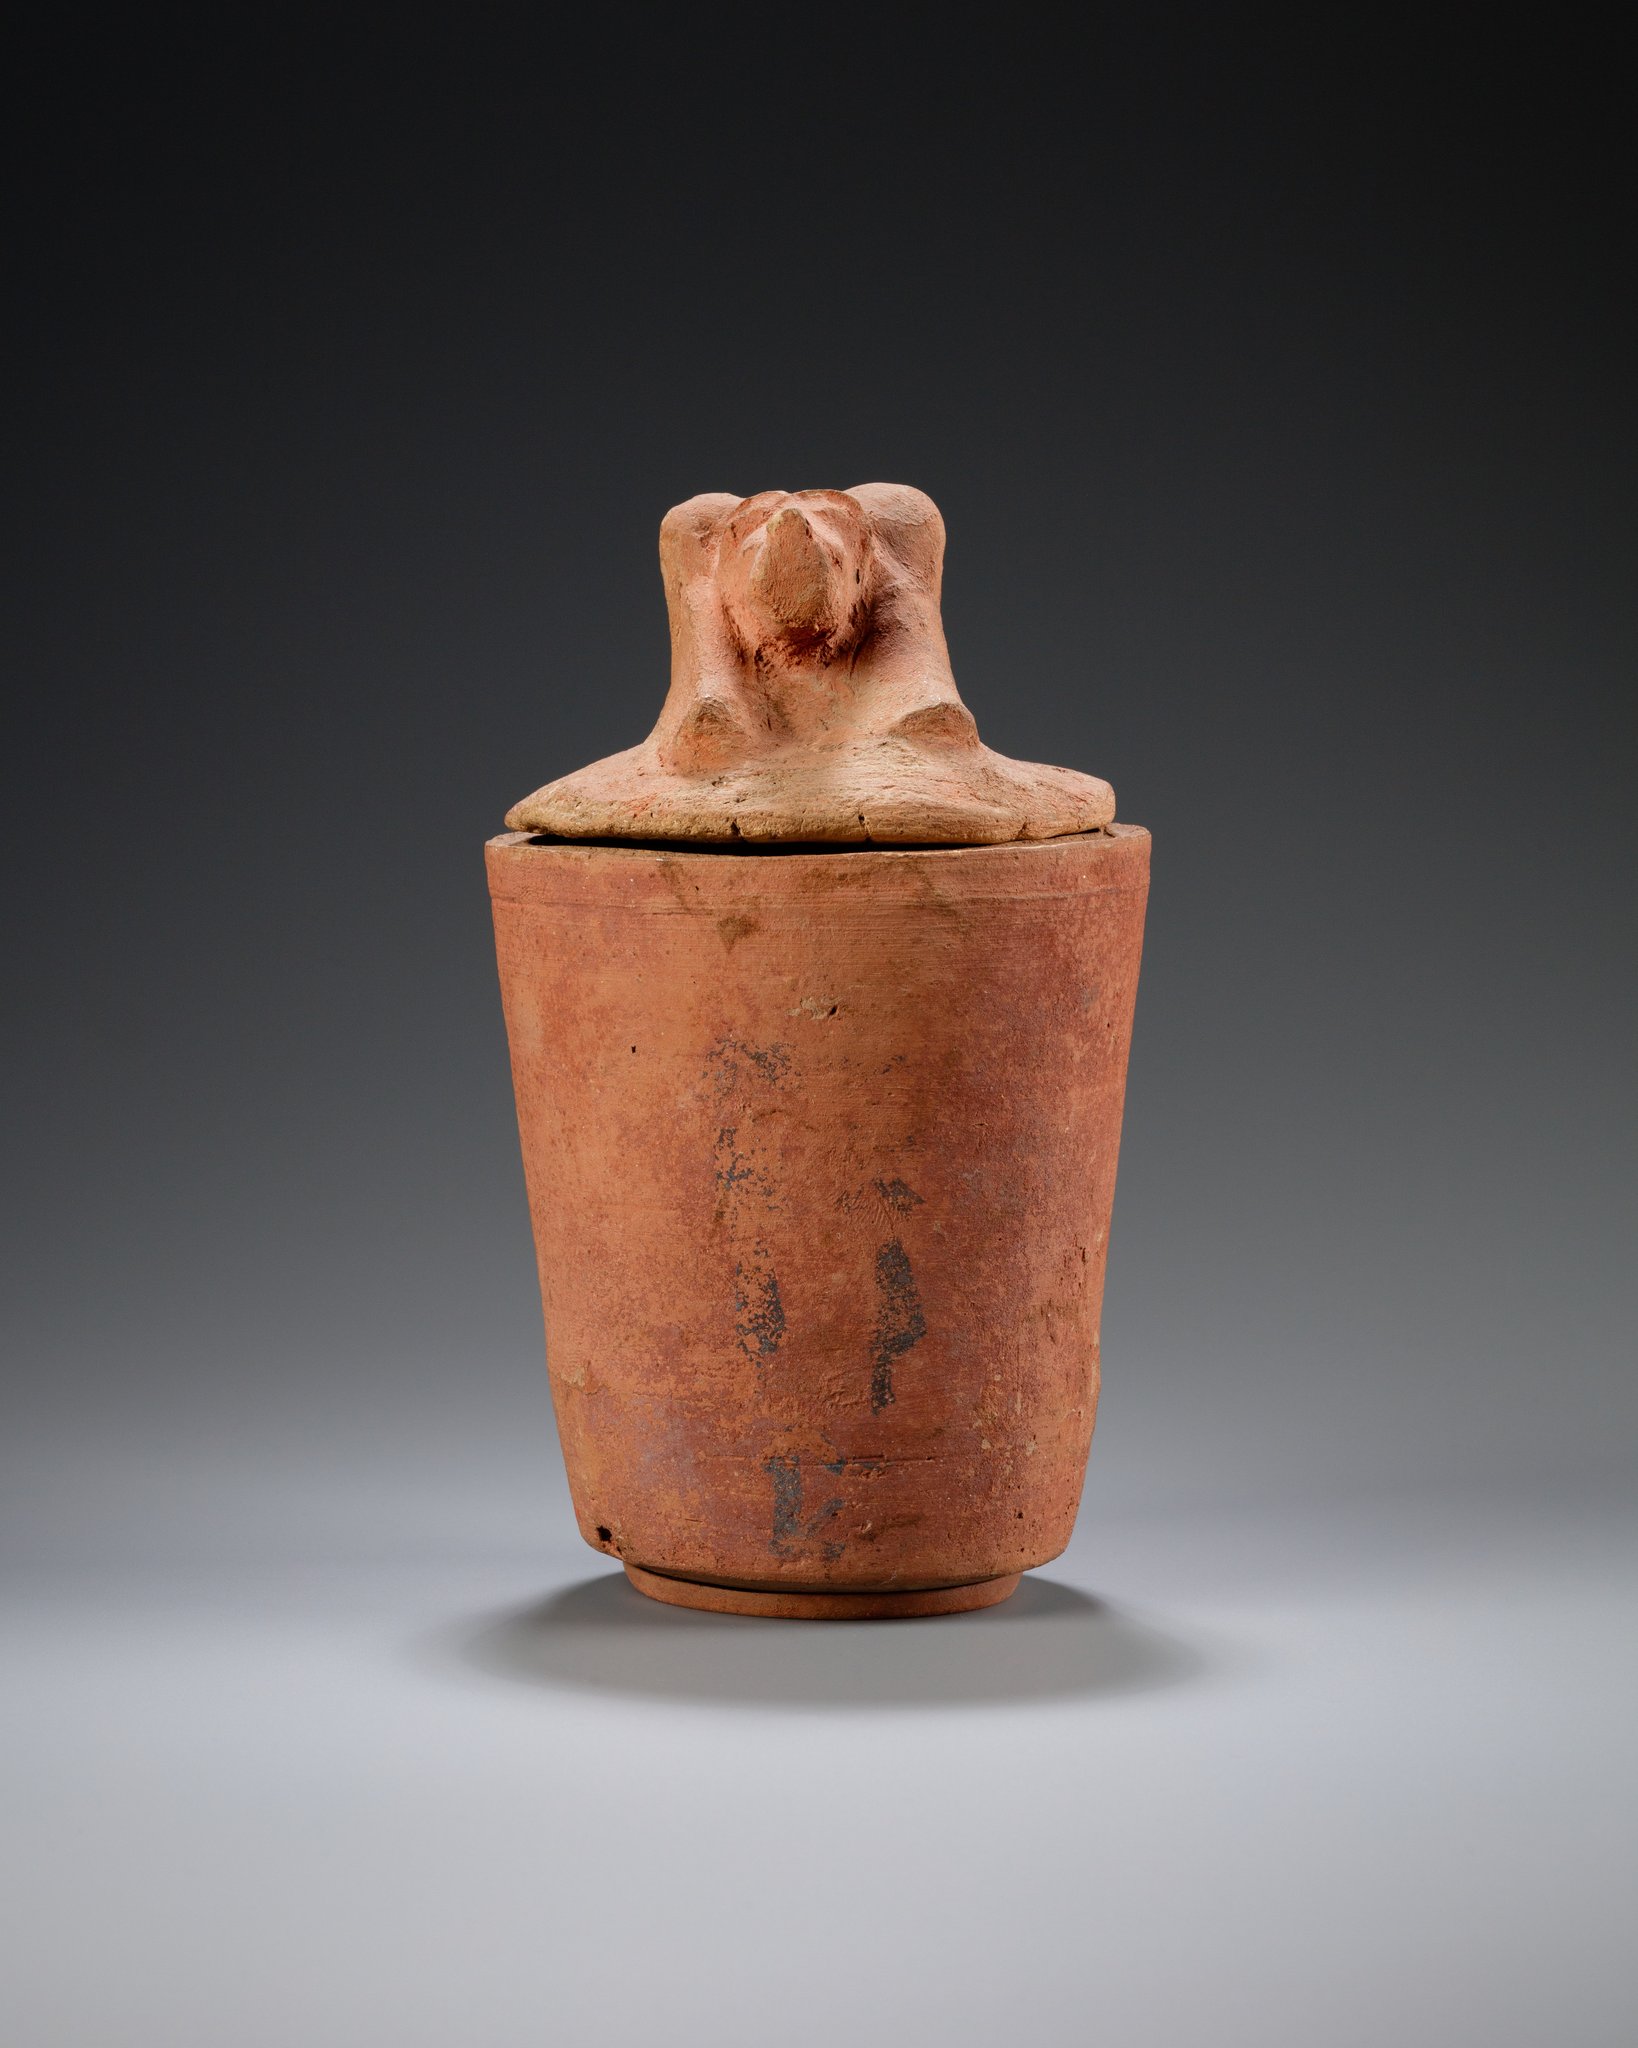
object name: canopic jar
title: Canopic jar with baboon head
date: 664-332 BCE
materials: paint, pottery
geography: egypt